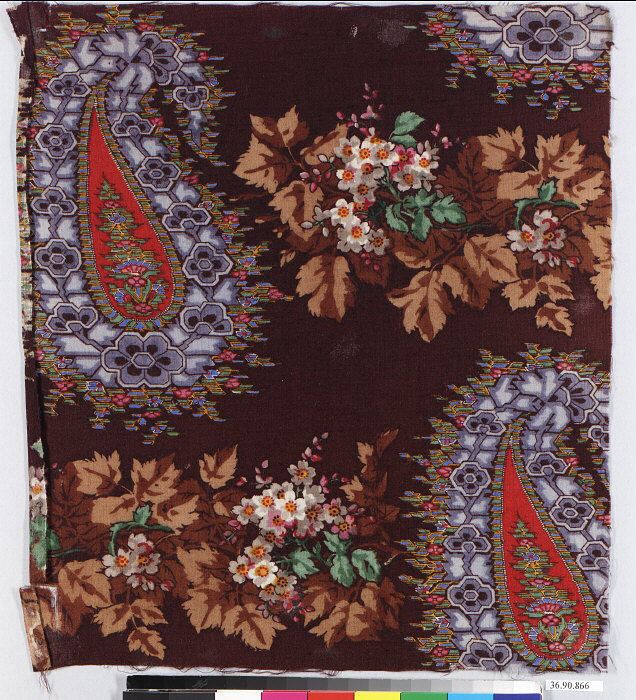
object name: piece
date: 1801-1900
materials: cotton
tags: flowers